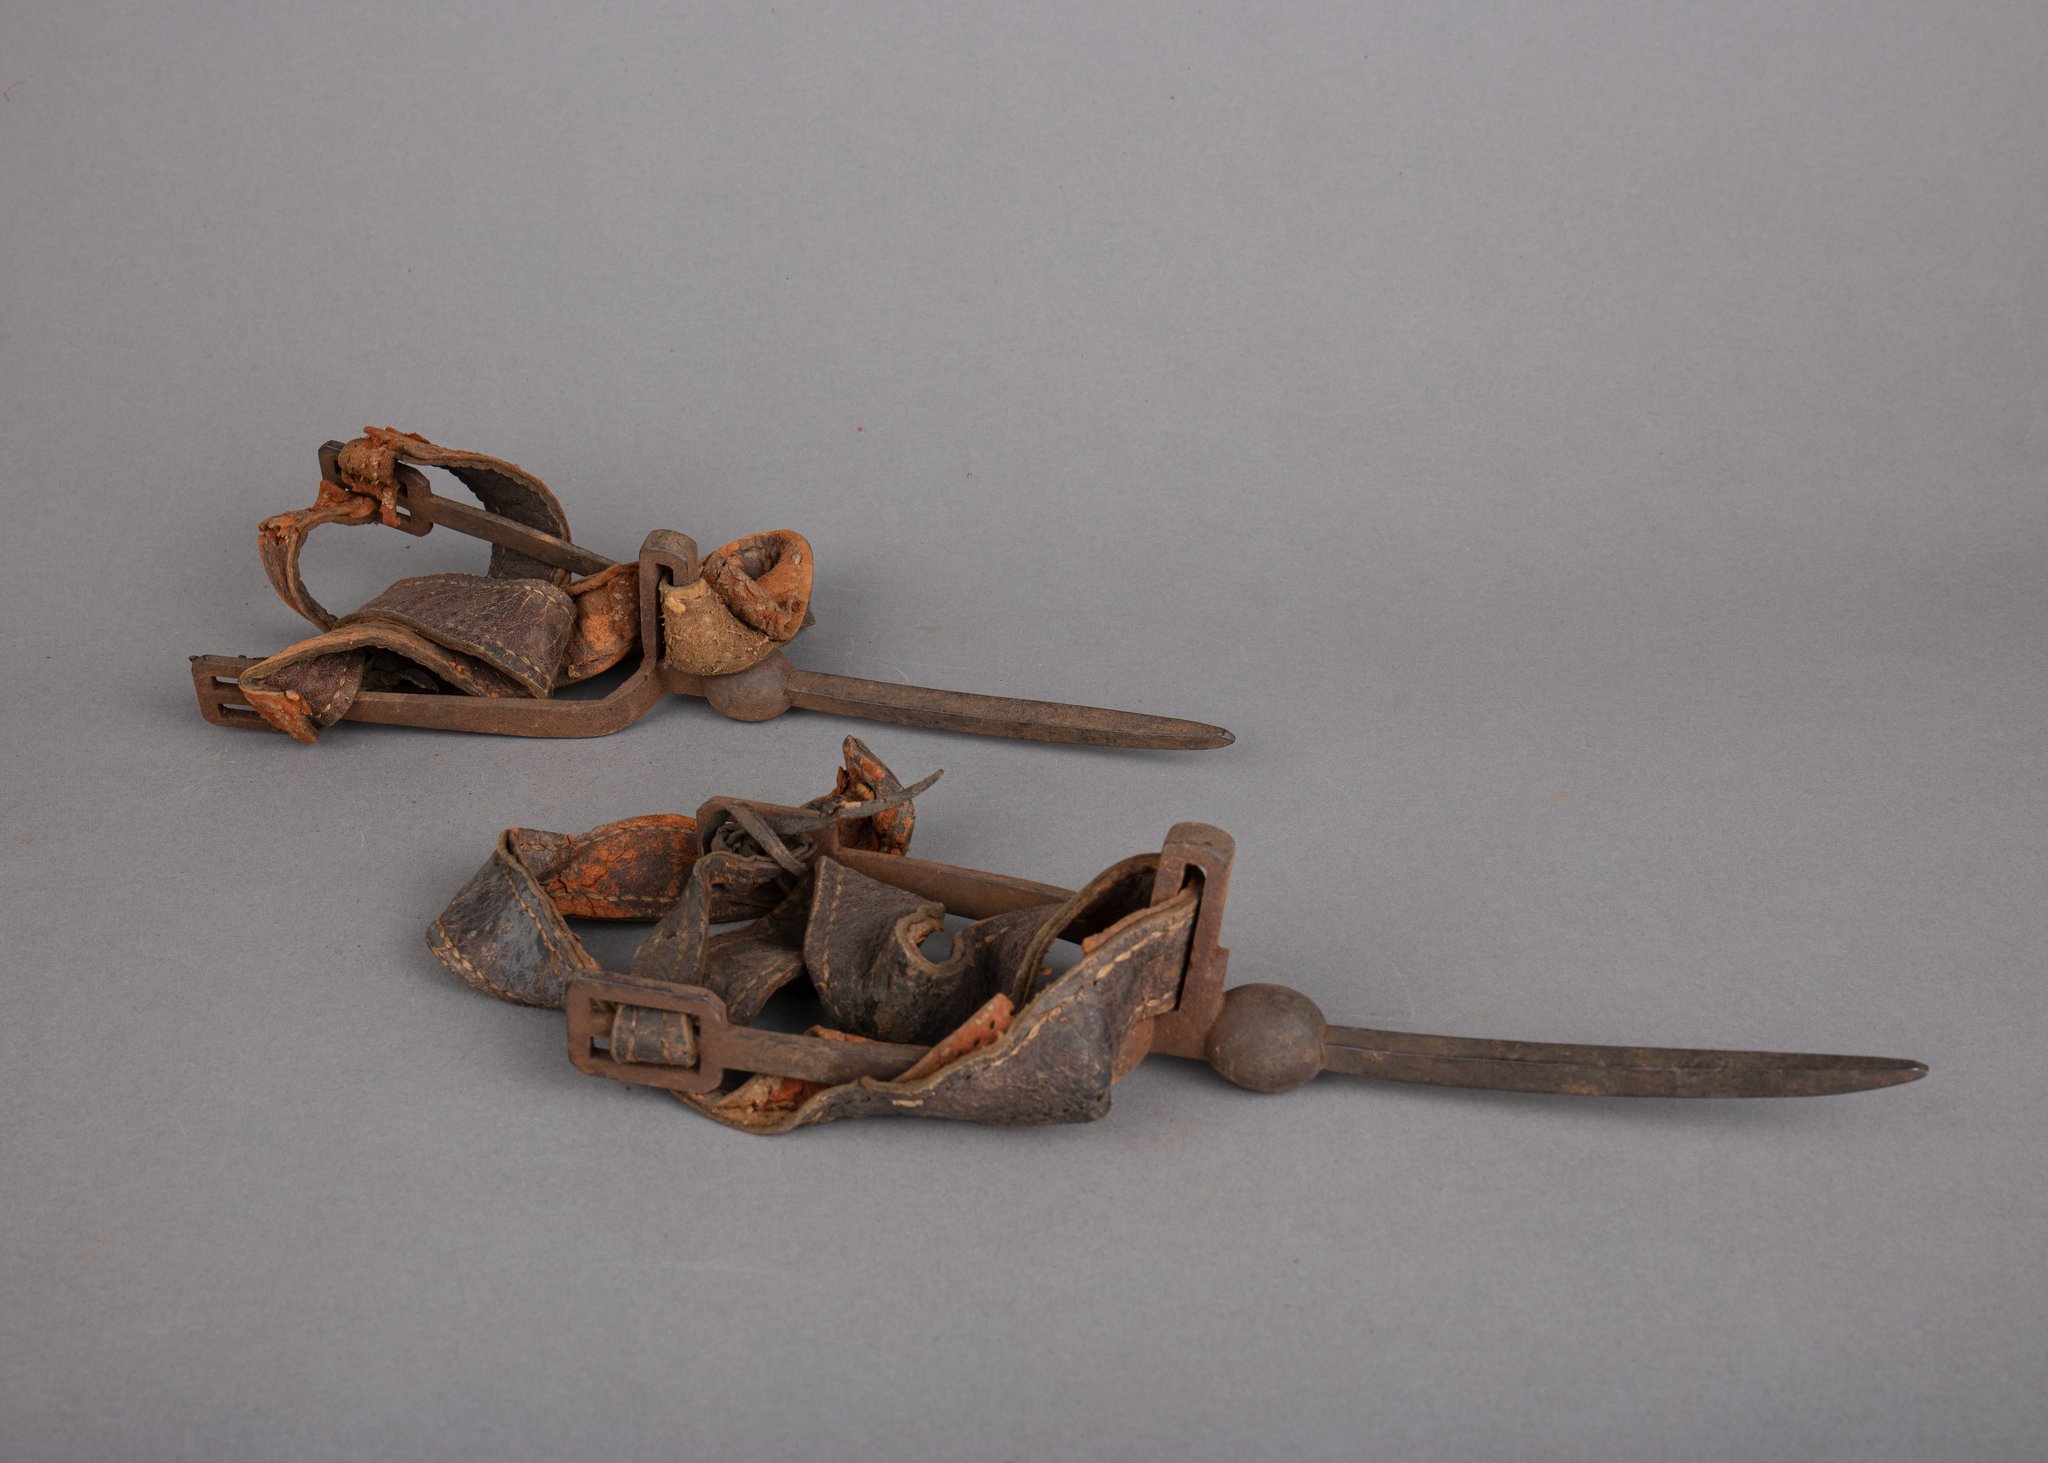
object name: spur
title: Pair of Prick Spurs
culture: algerian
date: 1867-1933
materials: iron, leather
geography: algeria